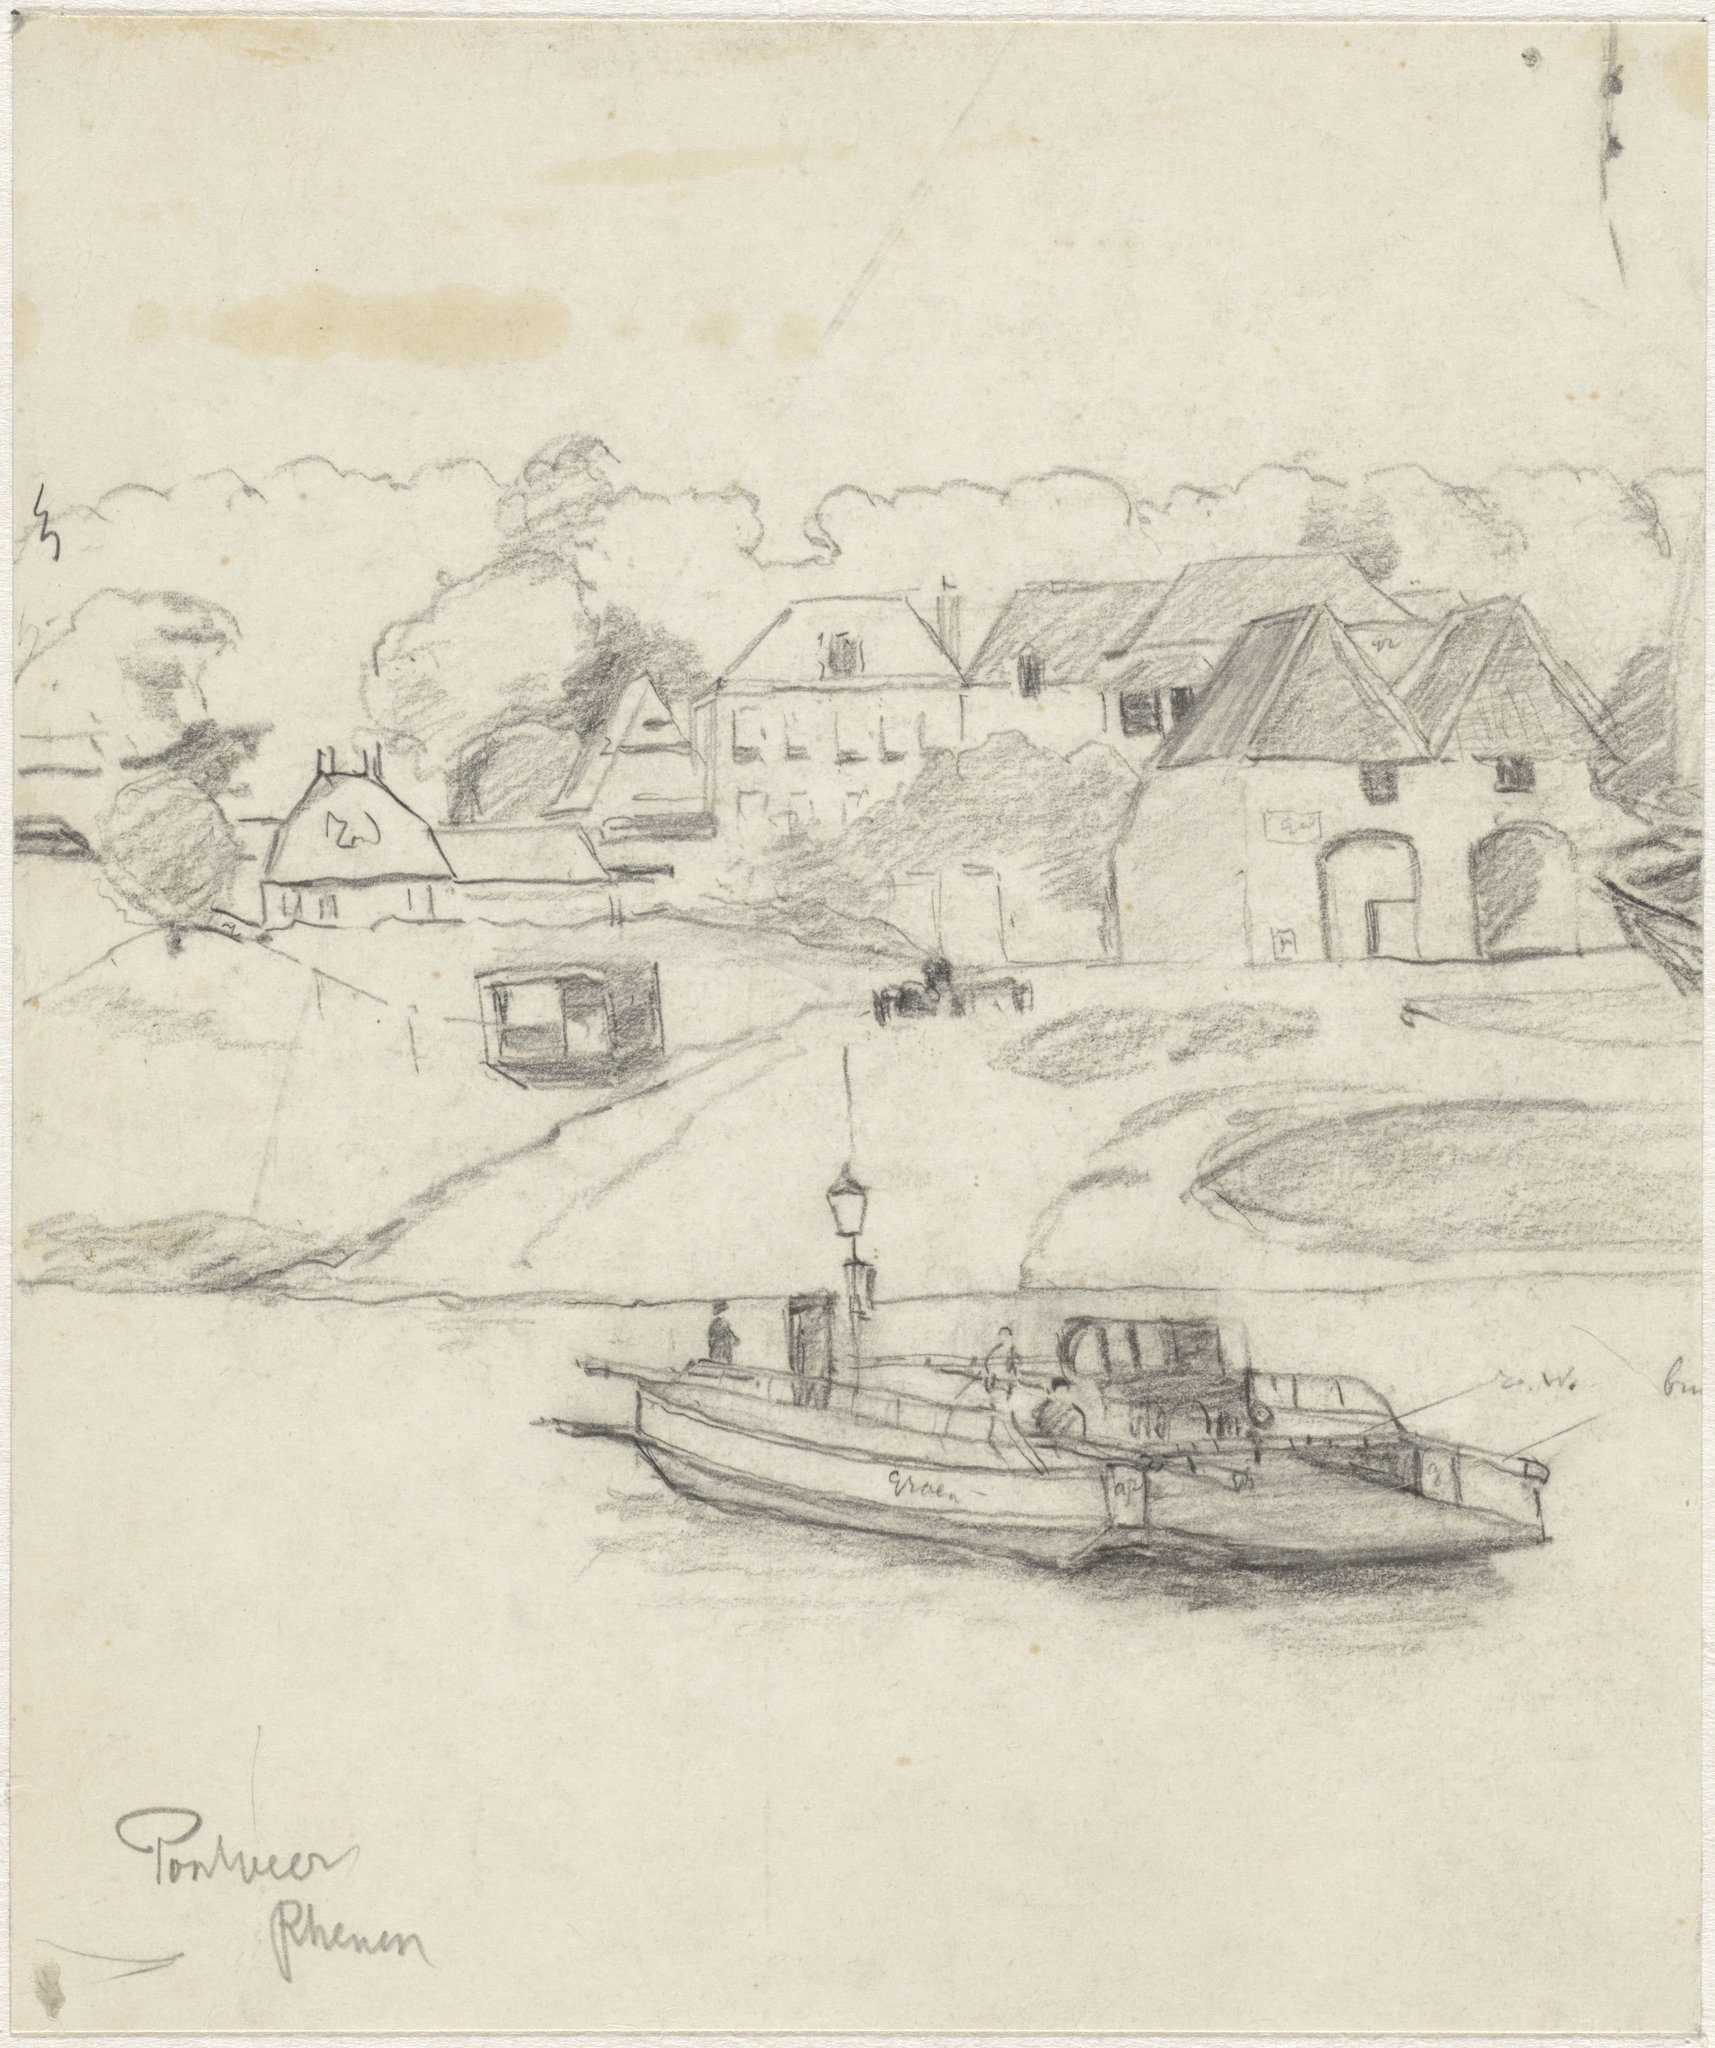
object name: drawing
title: Pontveer bij Rhenen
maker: johannes abraham mondt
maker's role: draughtsman, print maker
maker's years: 1859-1941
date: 1869-1941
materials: chalk, paper, pencil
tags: river, ferry, rhenen